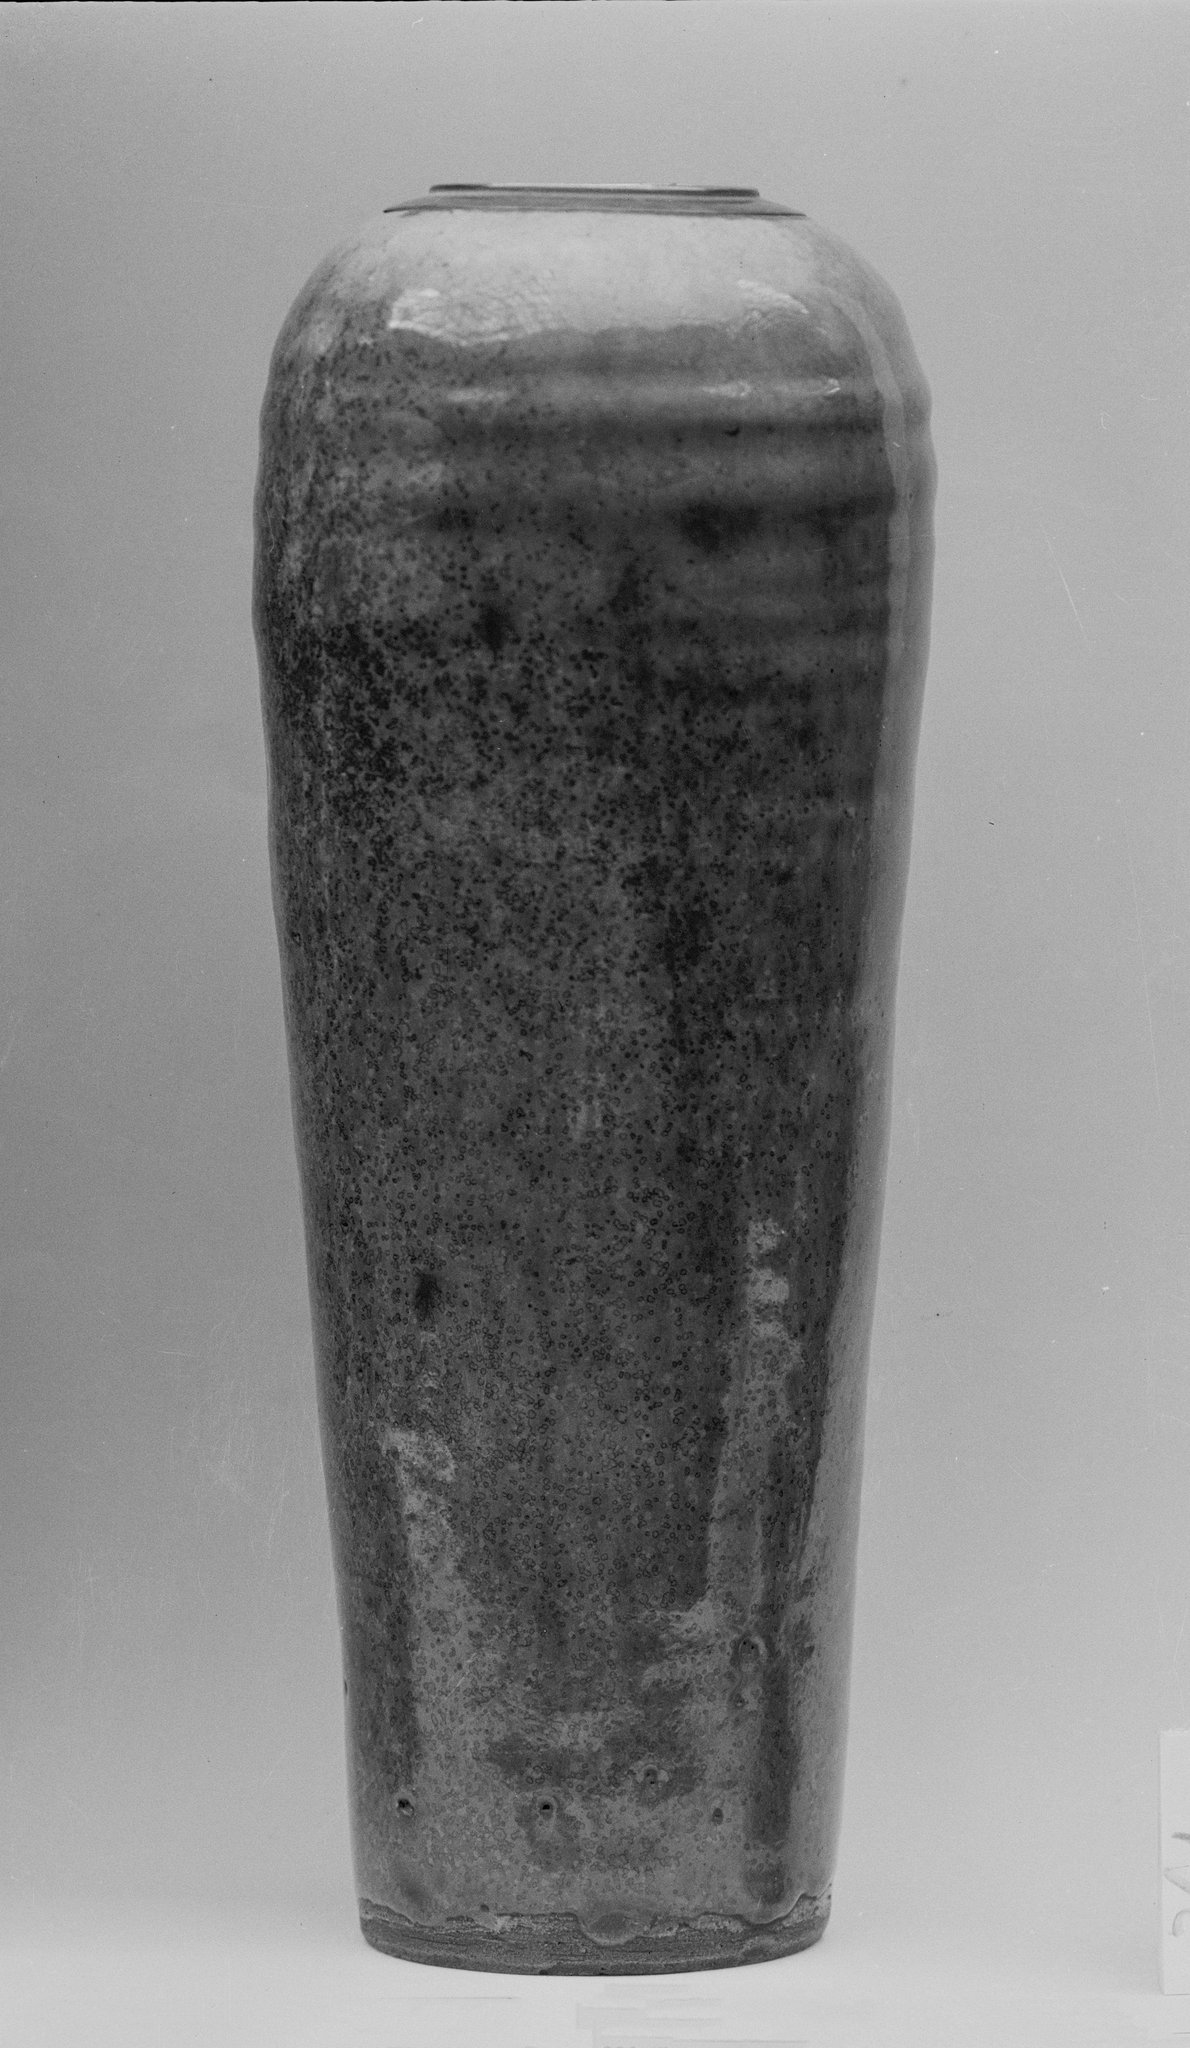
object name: vase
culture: japanese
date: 1800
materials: clay, glaze, metal